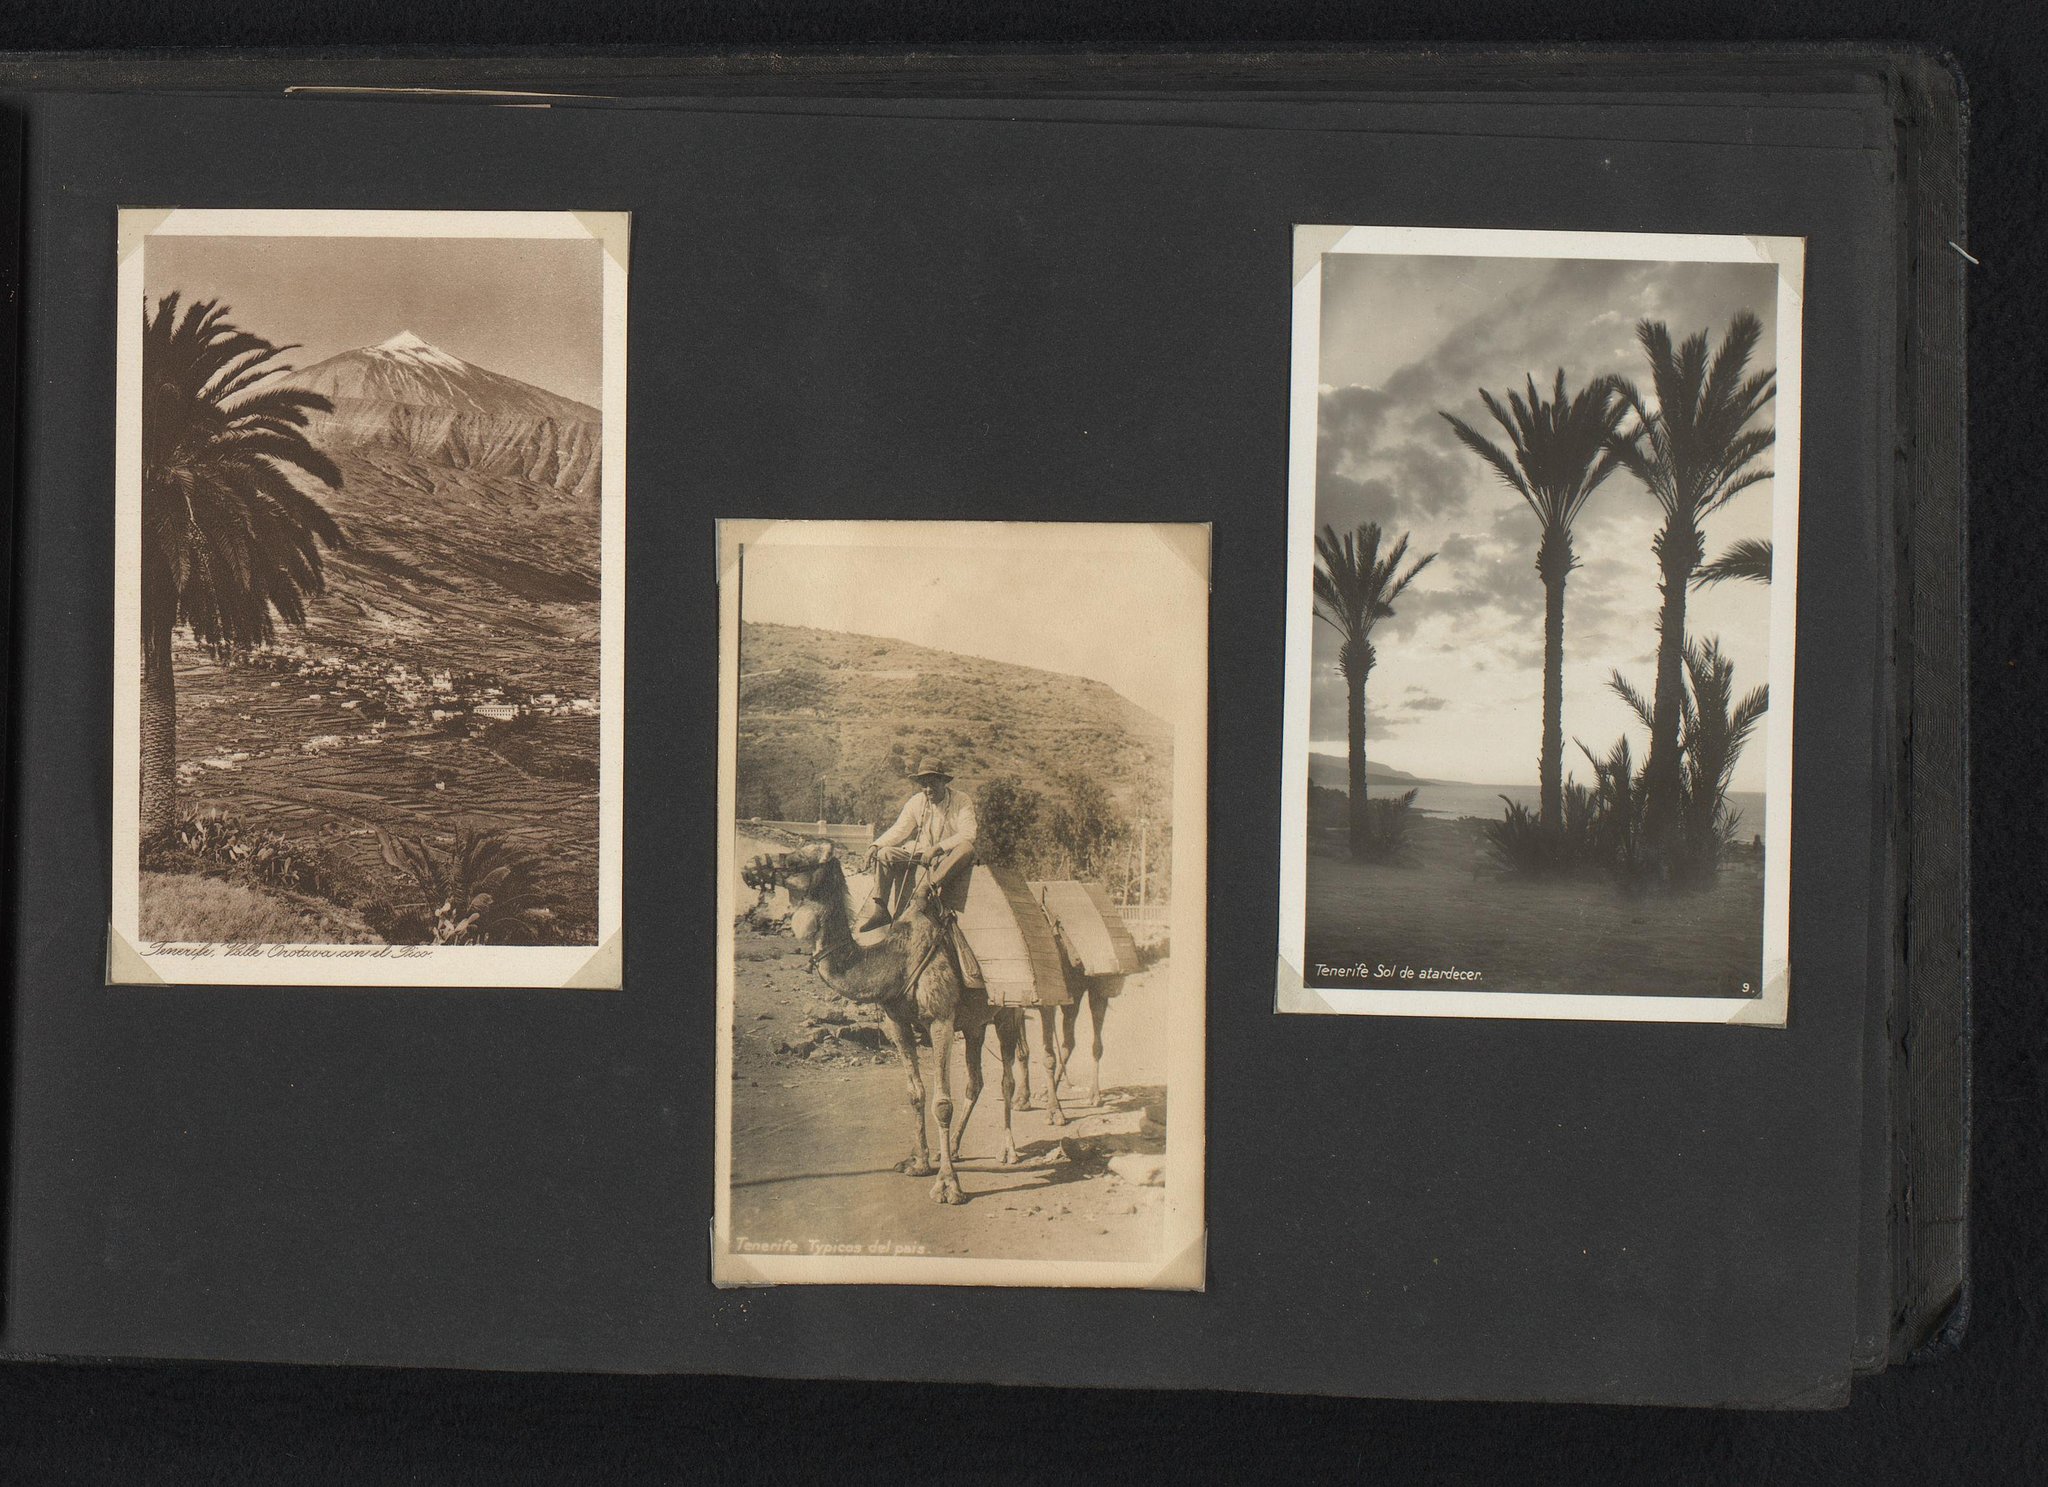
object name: ansichtkaart, prentbriefkaart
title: Drie prentbriefkaarten, waarvan twee fotografische en een fotomechanische, van Tenerife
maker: Anonymous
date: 1933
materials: paper, cardboard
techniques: gelatin silver print, rotogravure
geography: tenerife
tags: hoofed animals: camel, trees: palm-tree, mountains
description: Deze foto's en prent maken deel uit van een album.